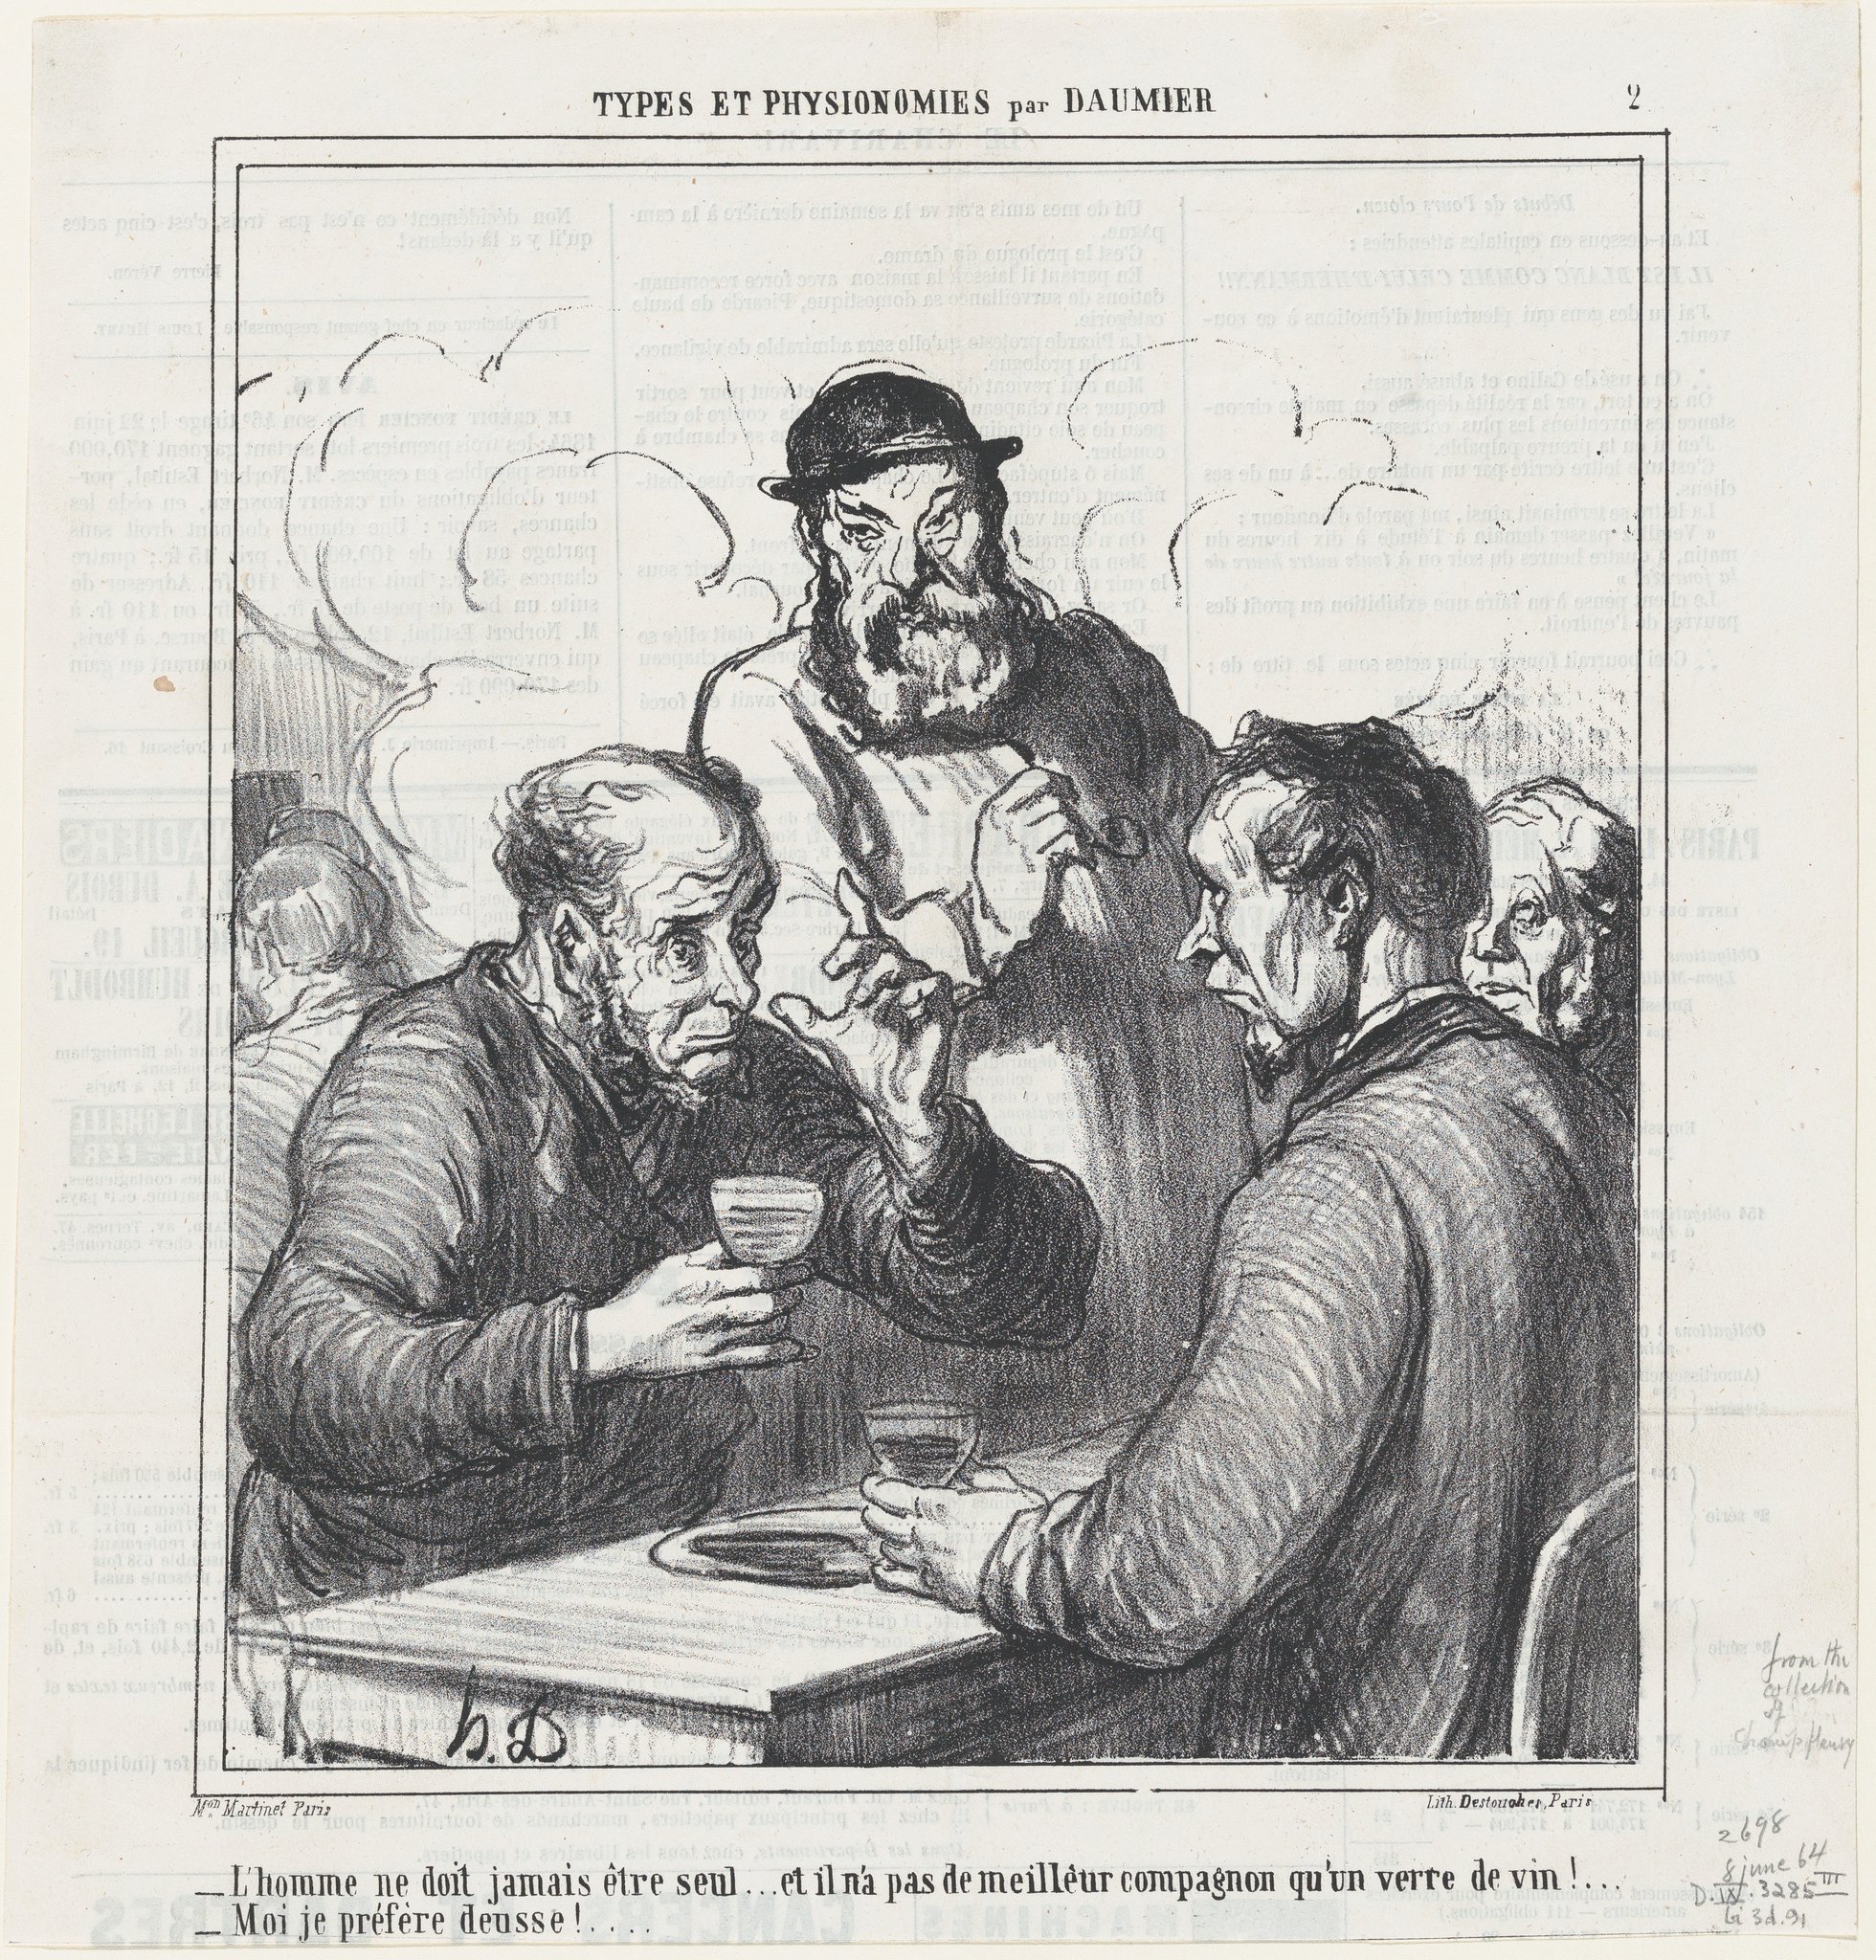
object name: print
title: A philosopher, from 'Types and features,' published in Le Charivari, June 8, 1864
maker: honoré daumier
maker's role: artist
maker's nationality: french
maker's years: 1808-1879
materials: paper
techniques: lithograph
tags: satire,men,philosophers